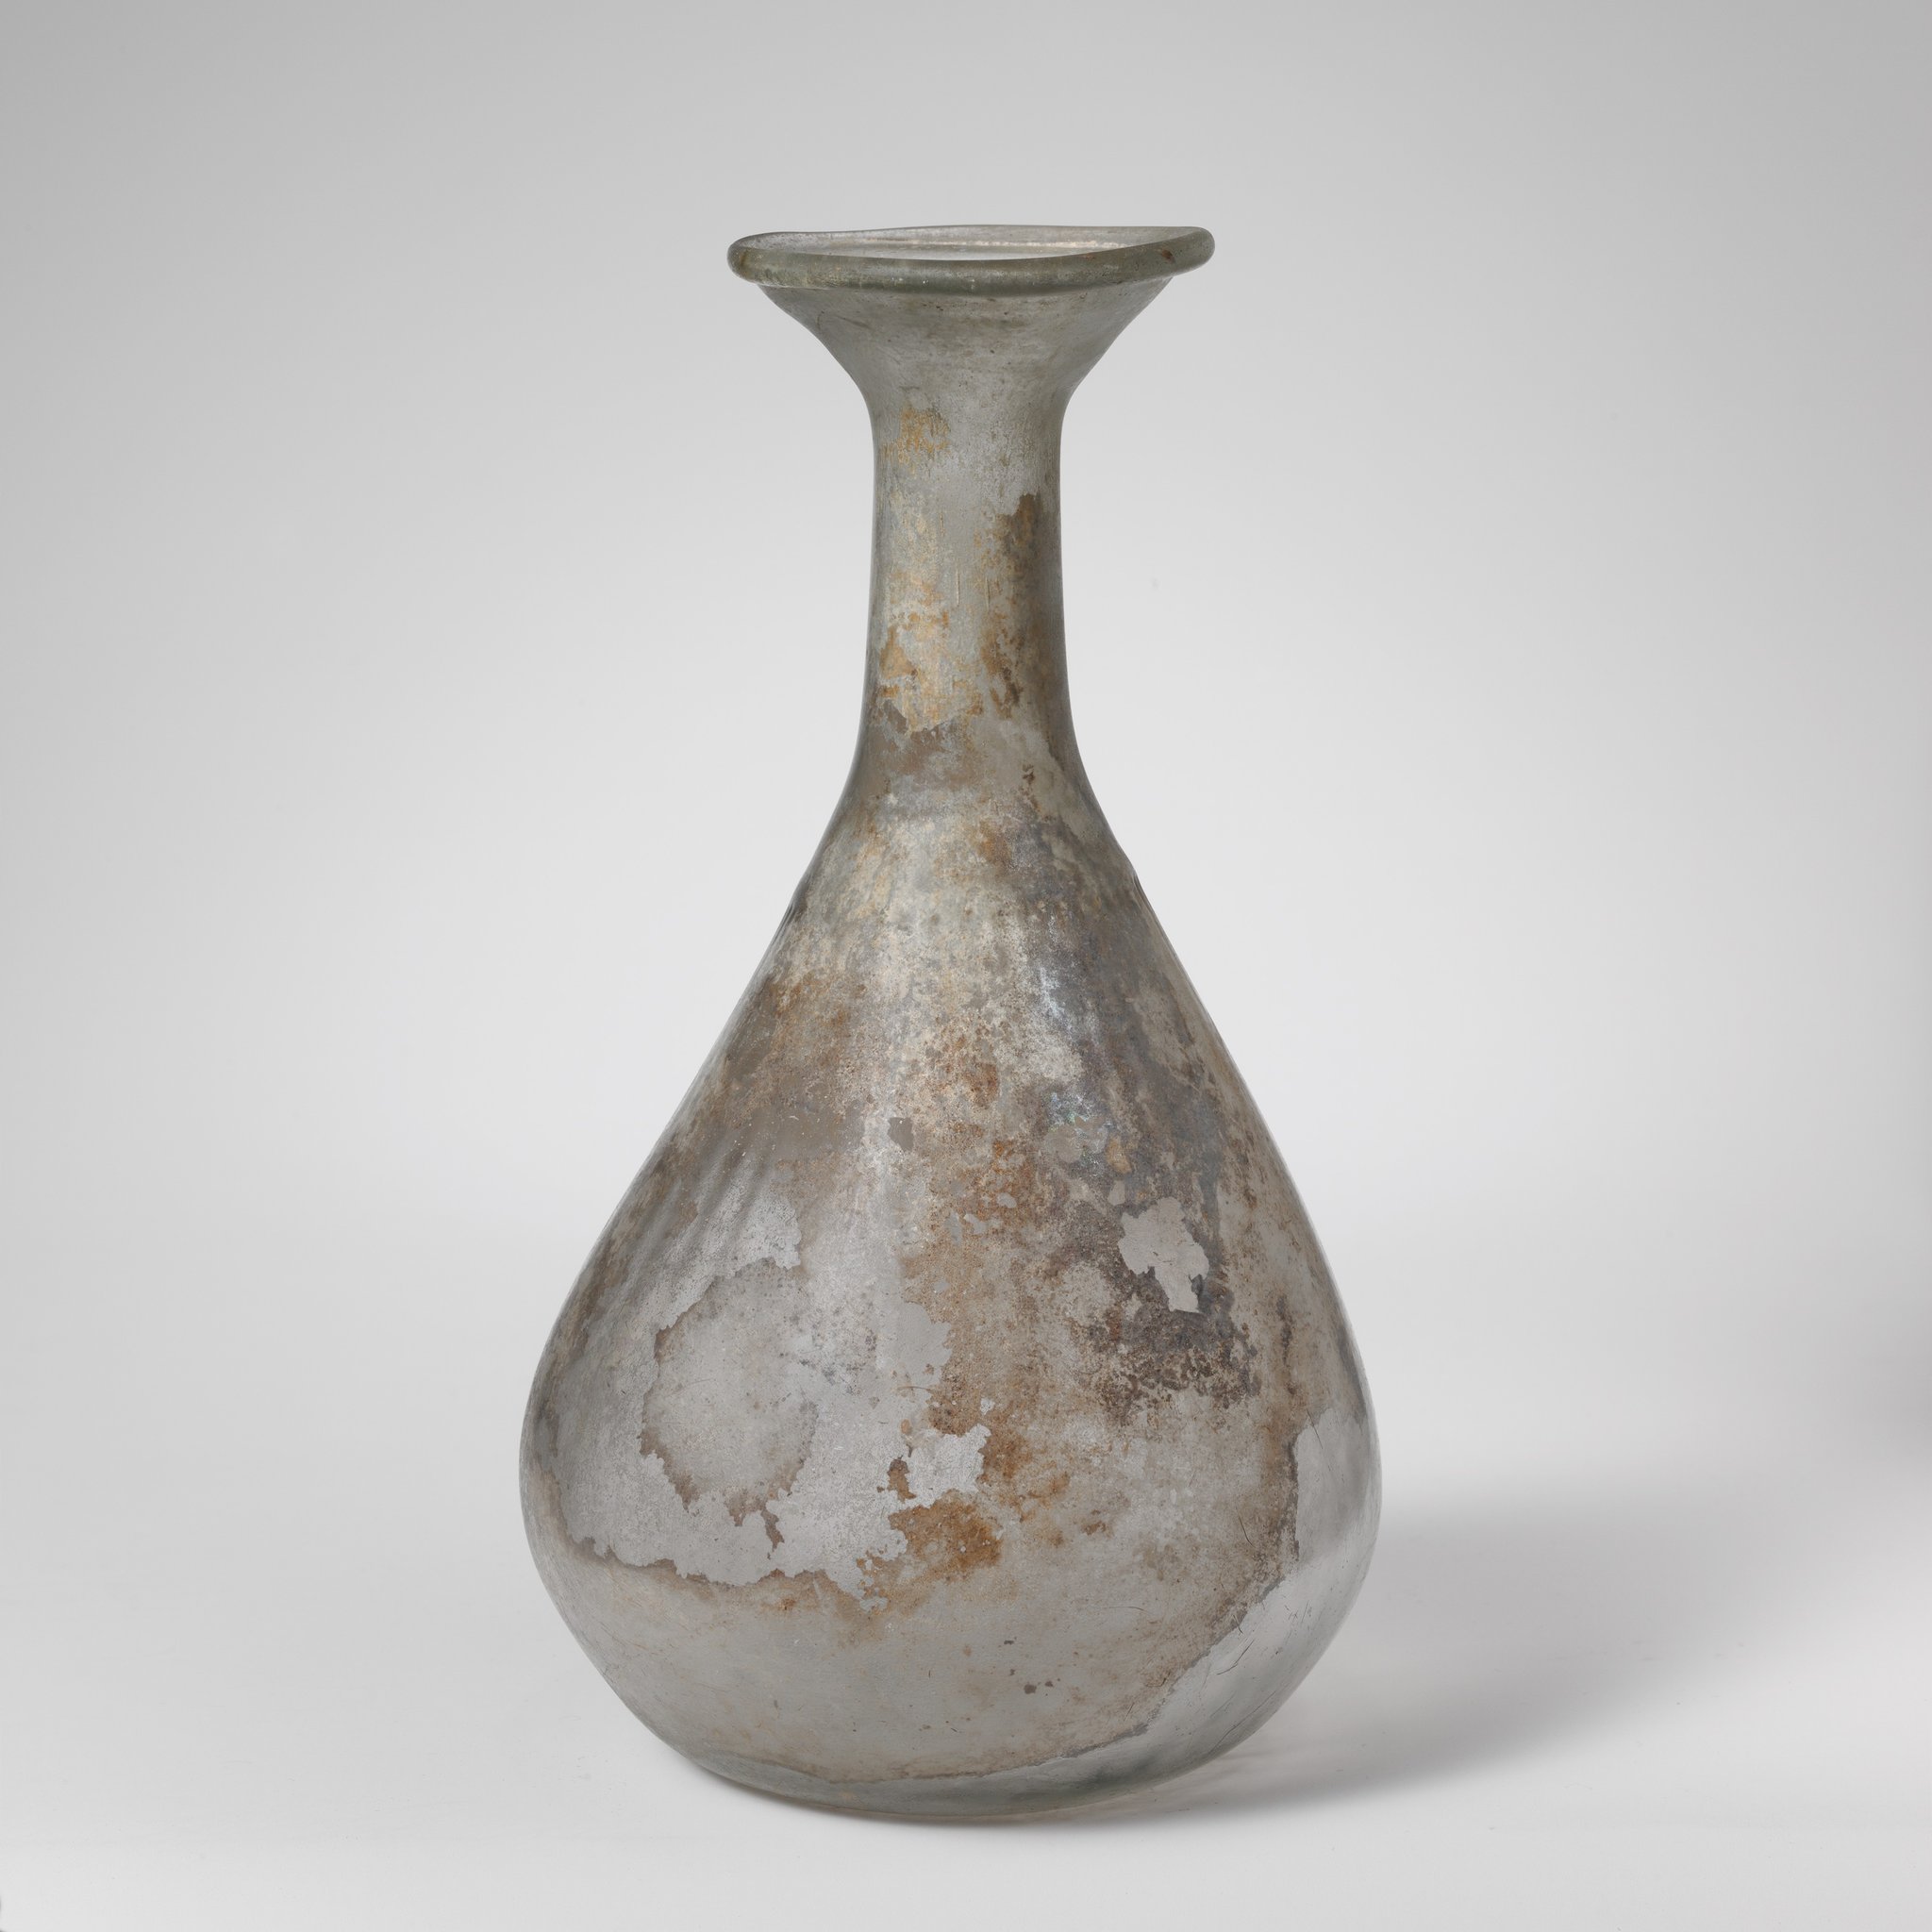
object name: flask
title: Glass flask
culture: roman, syrian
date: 201-400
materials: glass